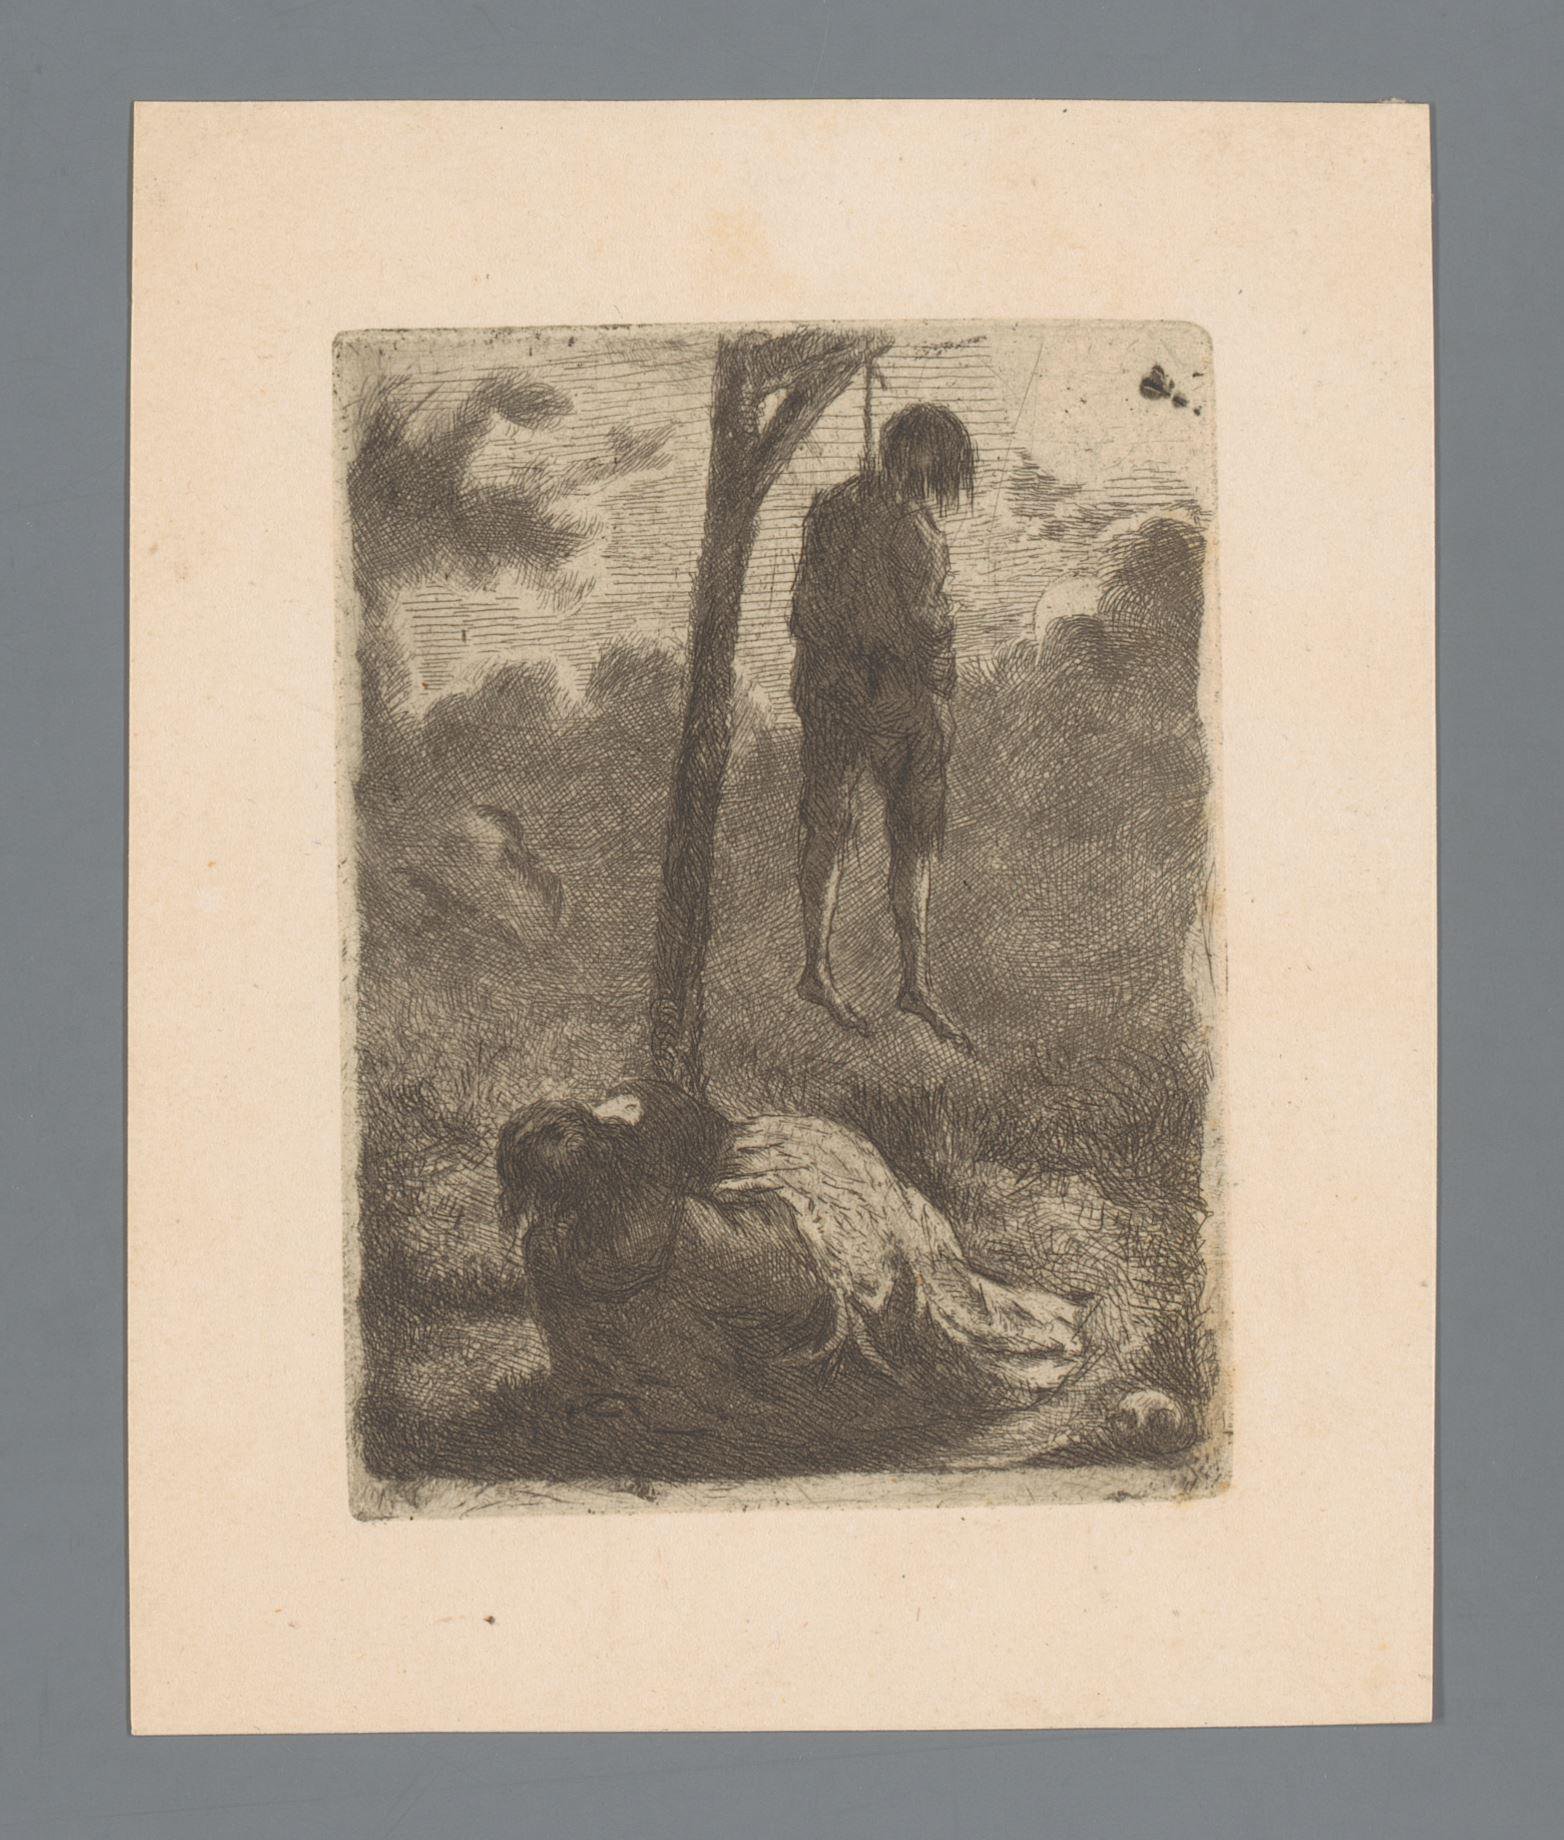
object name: print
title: Rouwend persoon aan de voet van een galg met een gehangene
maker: willem linnig (ii)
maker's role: print maker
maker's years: 1842-1890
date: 1852-1890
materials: paper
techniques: etching, intaglio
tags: violent death by hanging, mourning the dead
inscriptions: collector's mark: Lugt 1485, collector's mark: Lugt 2228